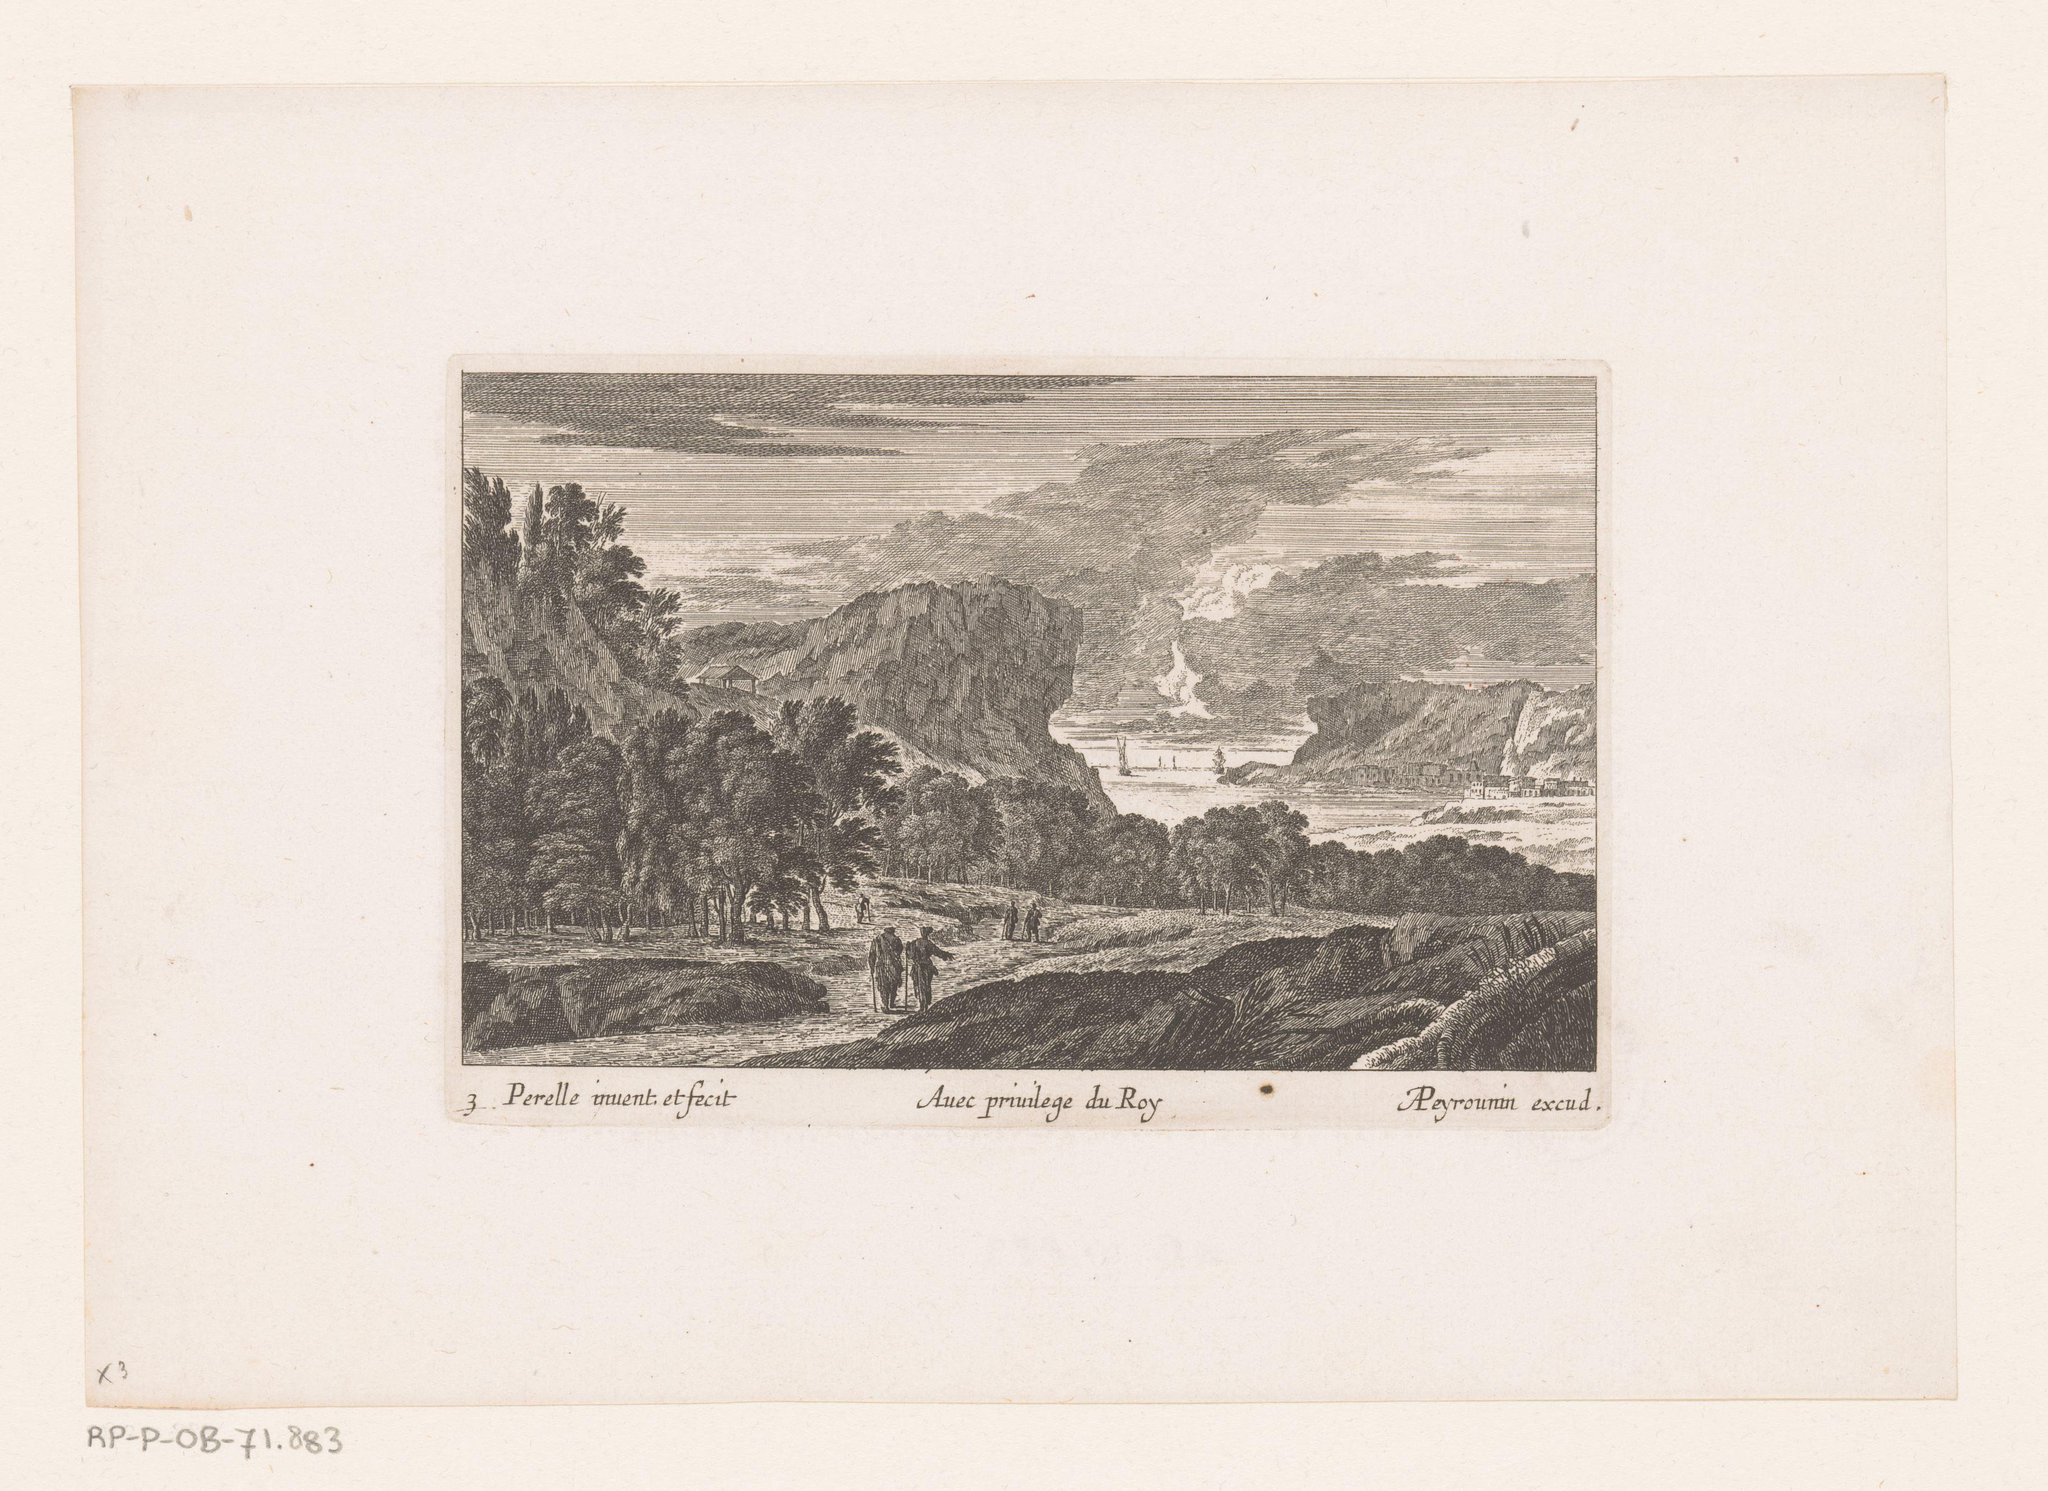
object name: print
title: Berglandschap met wandelaars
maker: abraham peyrounin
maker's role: publisher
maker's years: 1620-1666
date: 1630-1666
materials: paper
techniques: etching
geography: france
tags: mountains (+ landscape with figures, staffage)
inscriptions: collector's mark: Lugt 240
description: Prenten met het signatuur 'Perelle' kunnen zowel door vader Gabriel als door zonen Nicolas en Adam gemaakt zijn.